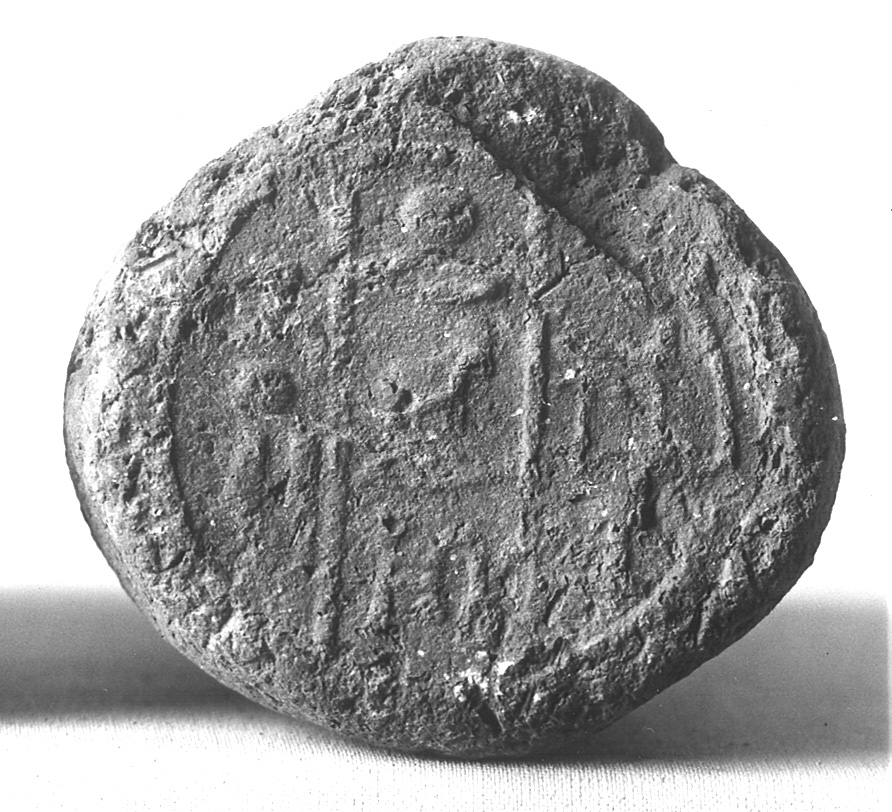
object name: cone, circular impression, aanen, scribe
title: Funerary Cone of the Scribe Anen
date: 1550-1352 BCE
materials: pottery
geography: egypt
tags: hieroglyphs